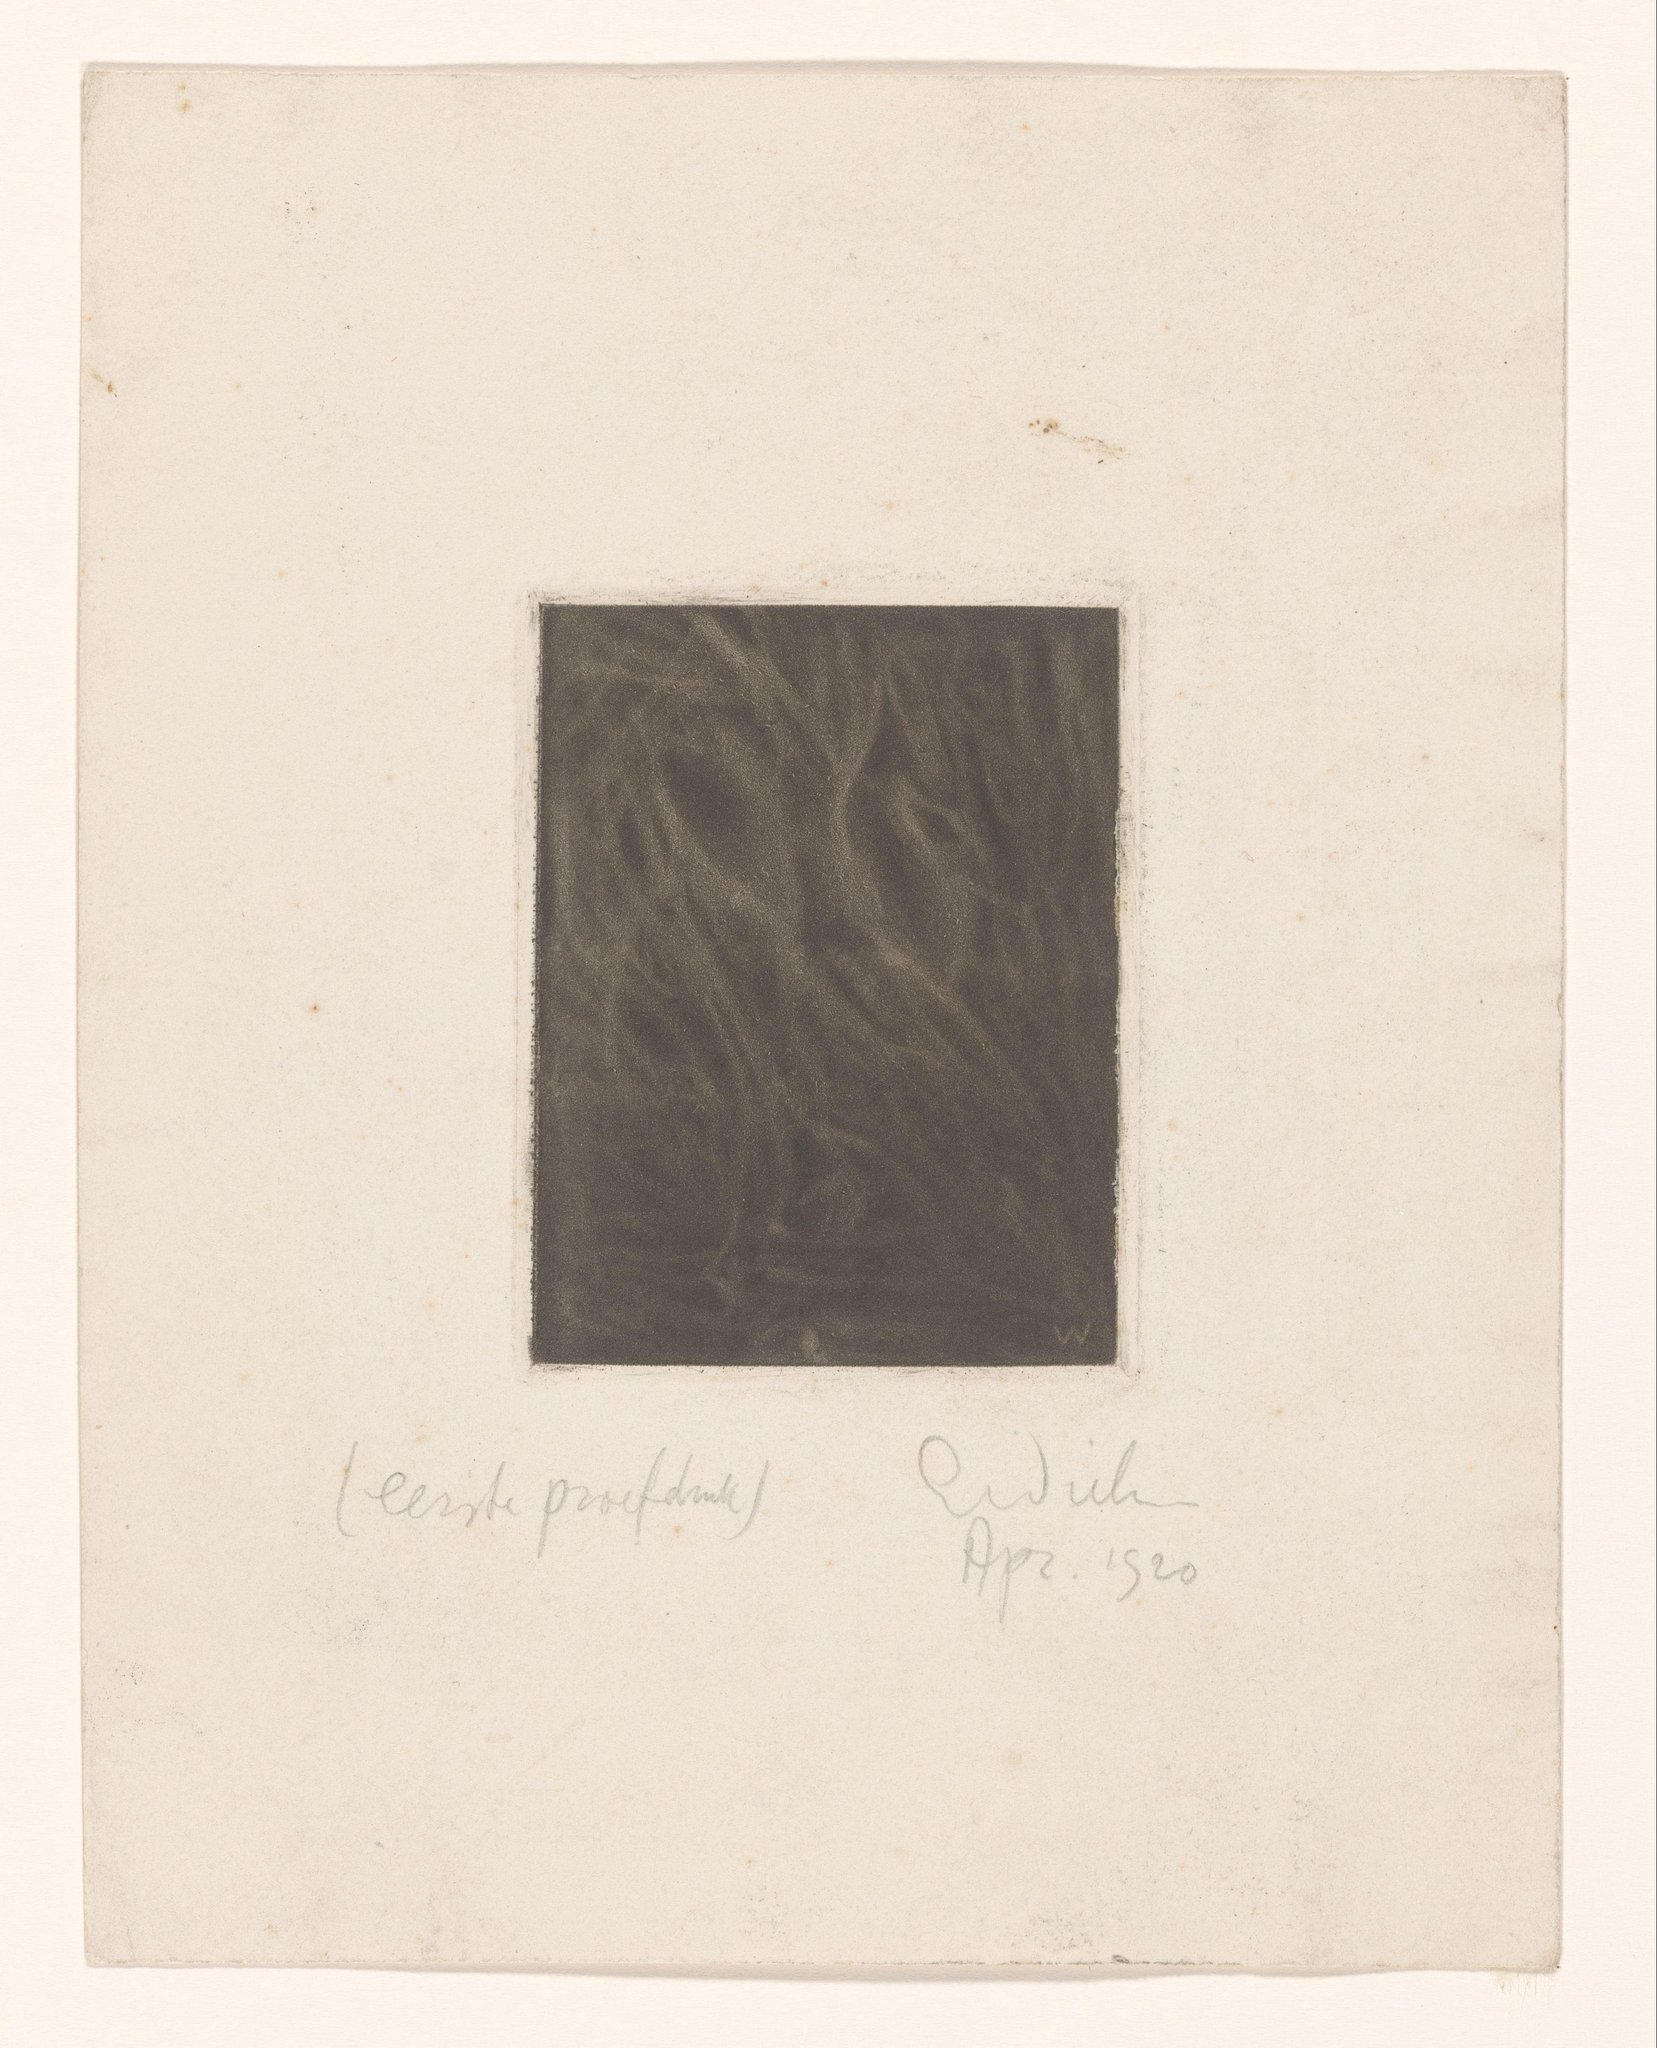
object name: print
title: Abstracte compositie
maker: erich wichmann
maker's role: print maker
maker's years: 1890-1929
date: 1904-1920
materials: paper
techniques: aquatint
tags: abstract, non-representational art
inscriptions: collector's mark: Lugt 2228